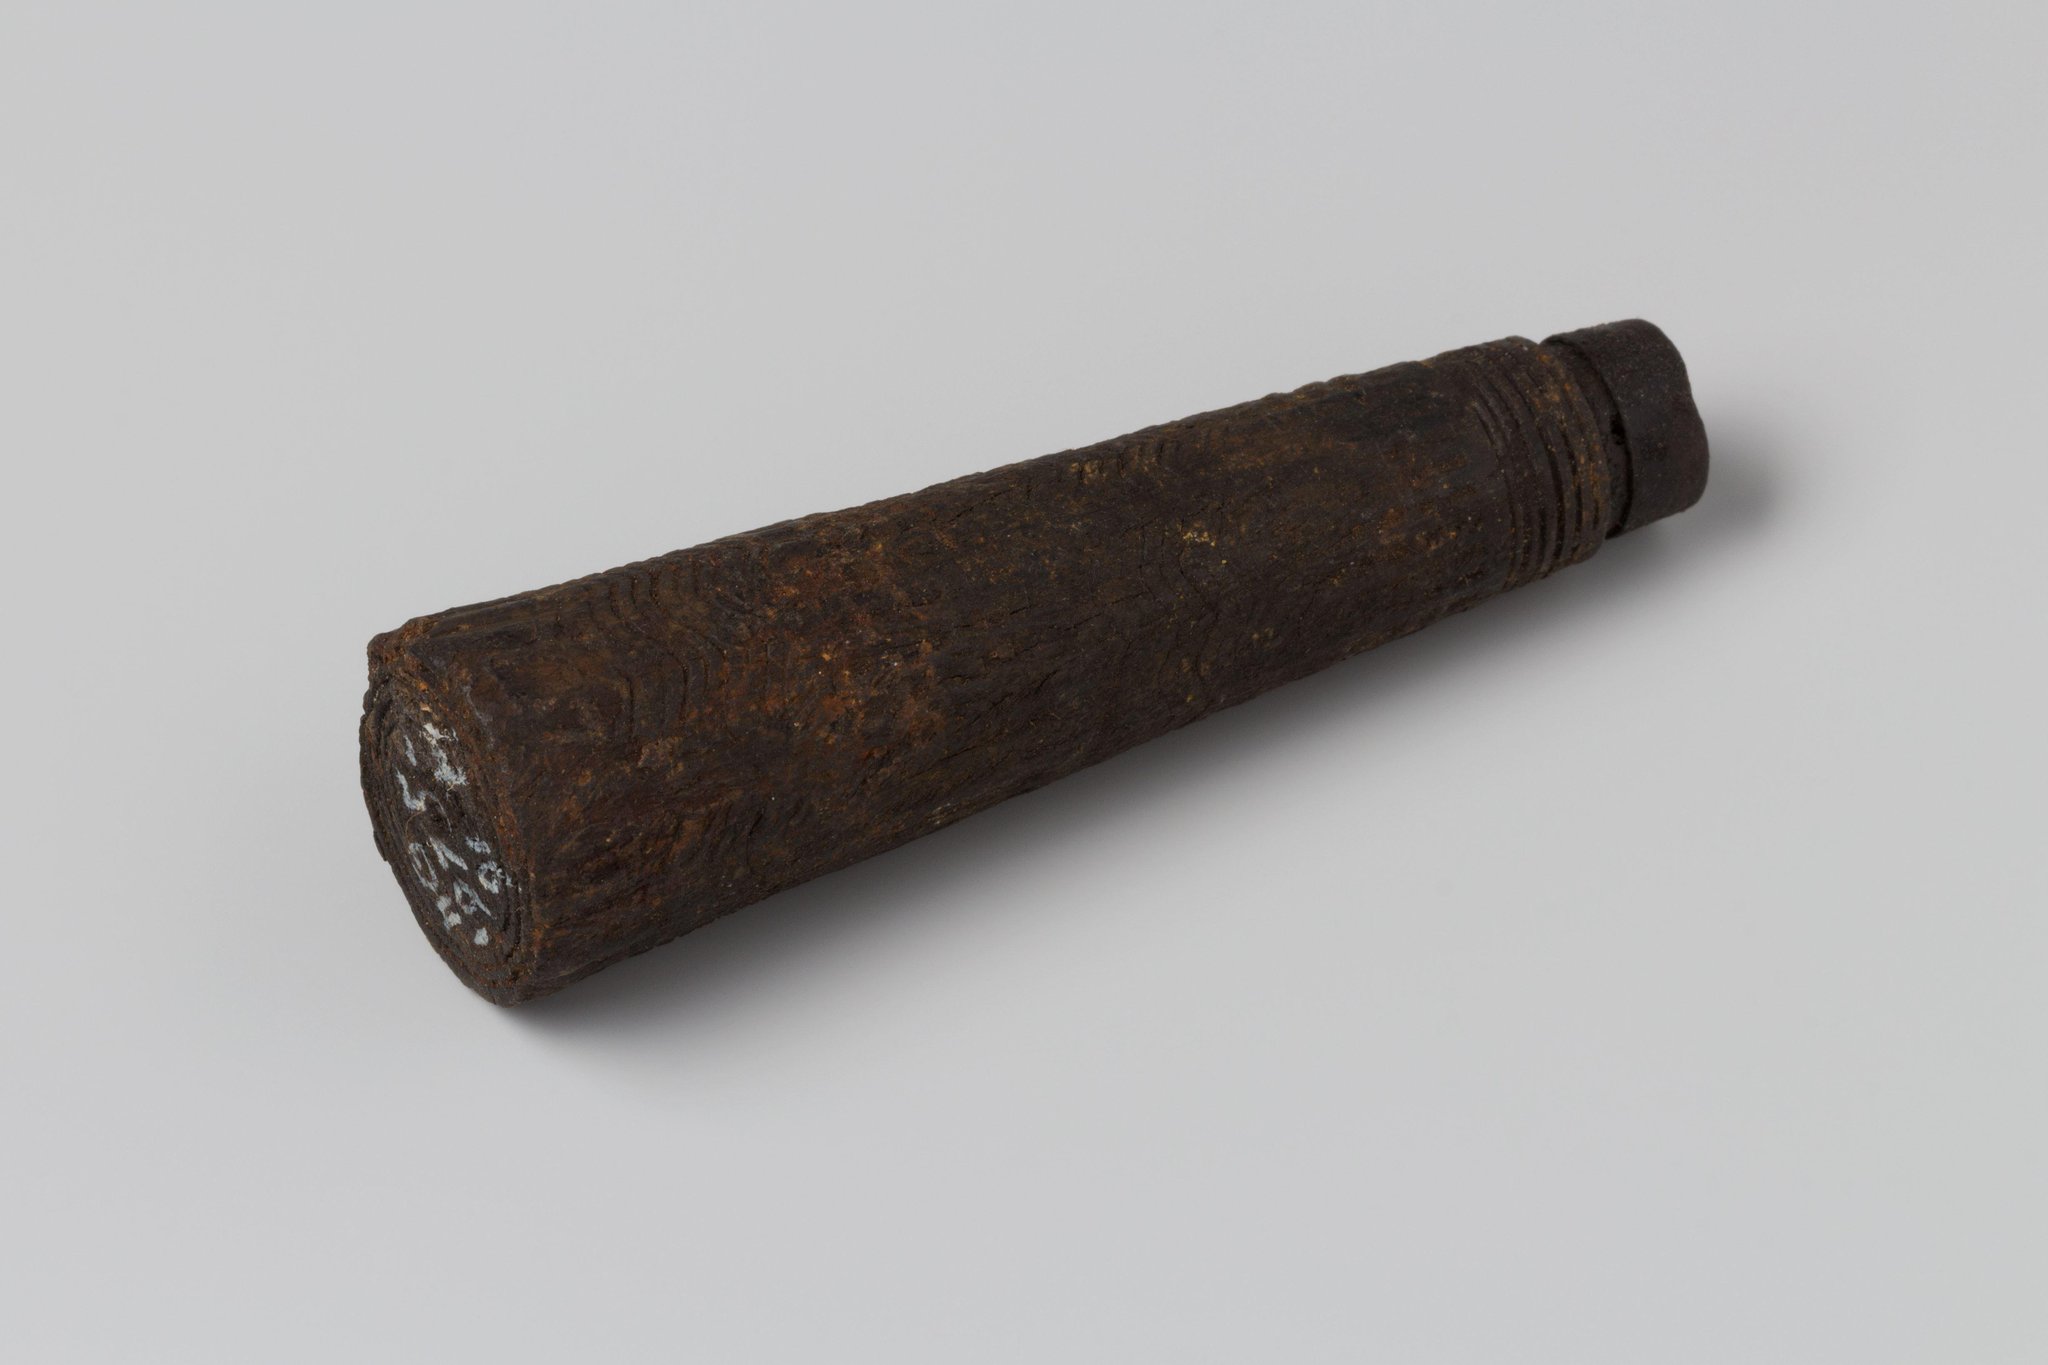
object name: knife handle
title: Messenheft uit het wrak van de Oost-Indiëvaarder Hollandia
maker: Anonymous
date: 1700-1743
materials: copper, wood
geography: netherlands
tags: verenigde oostindische compagnie, hollandia (schip), scilly-eilanden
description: Messenheft van hout. Hierbij behoort ook een los koperen ringetje, deze is los bijgevoegd